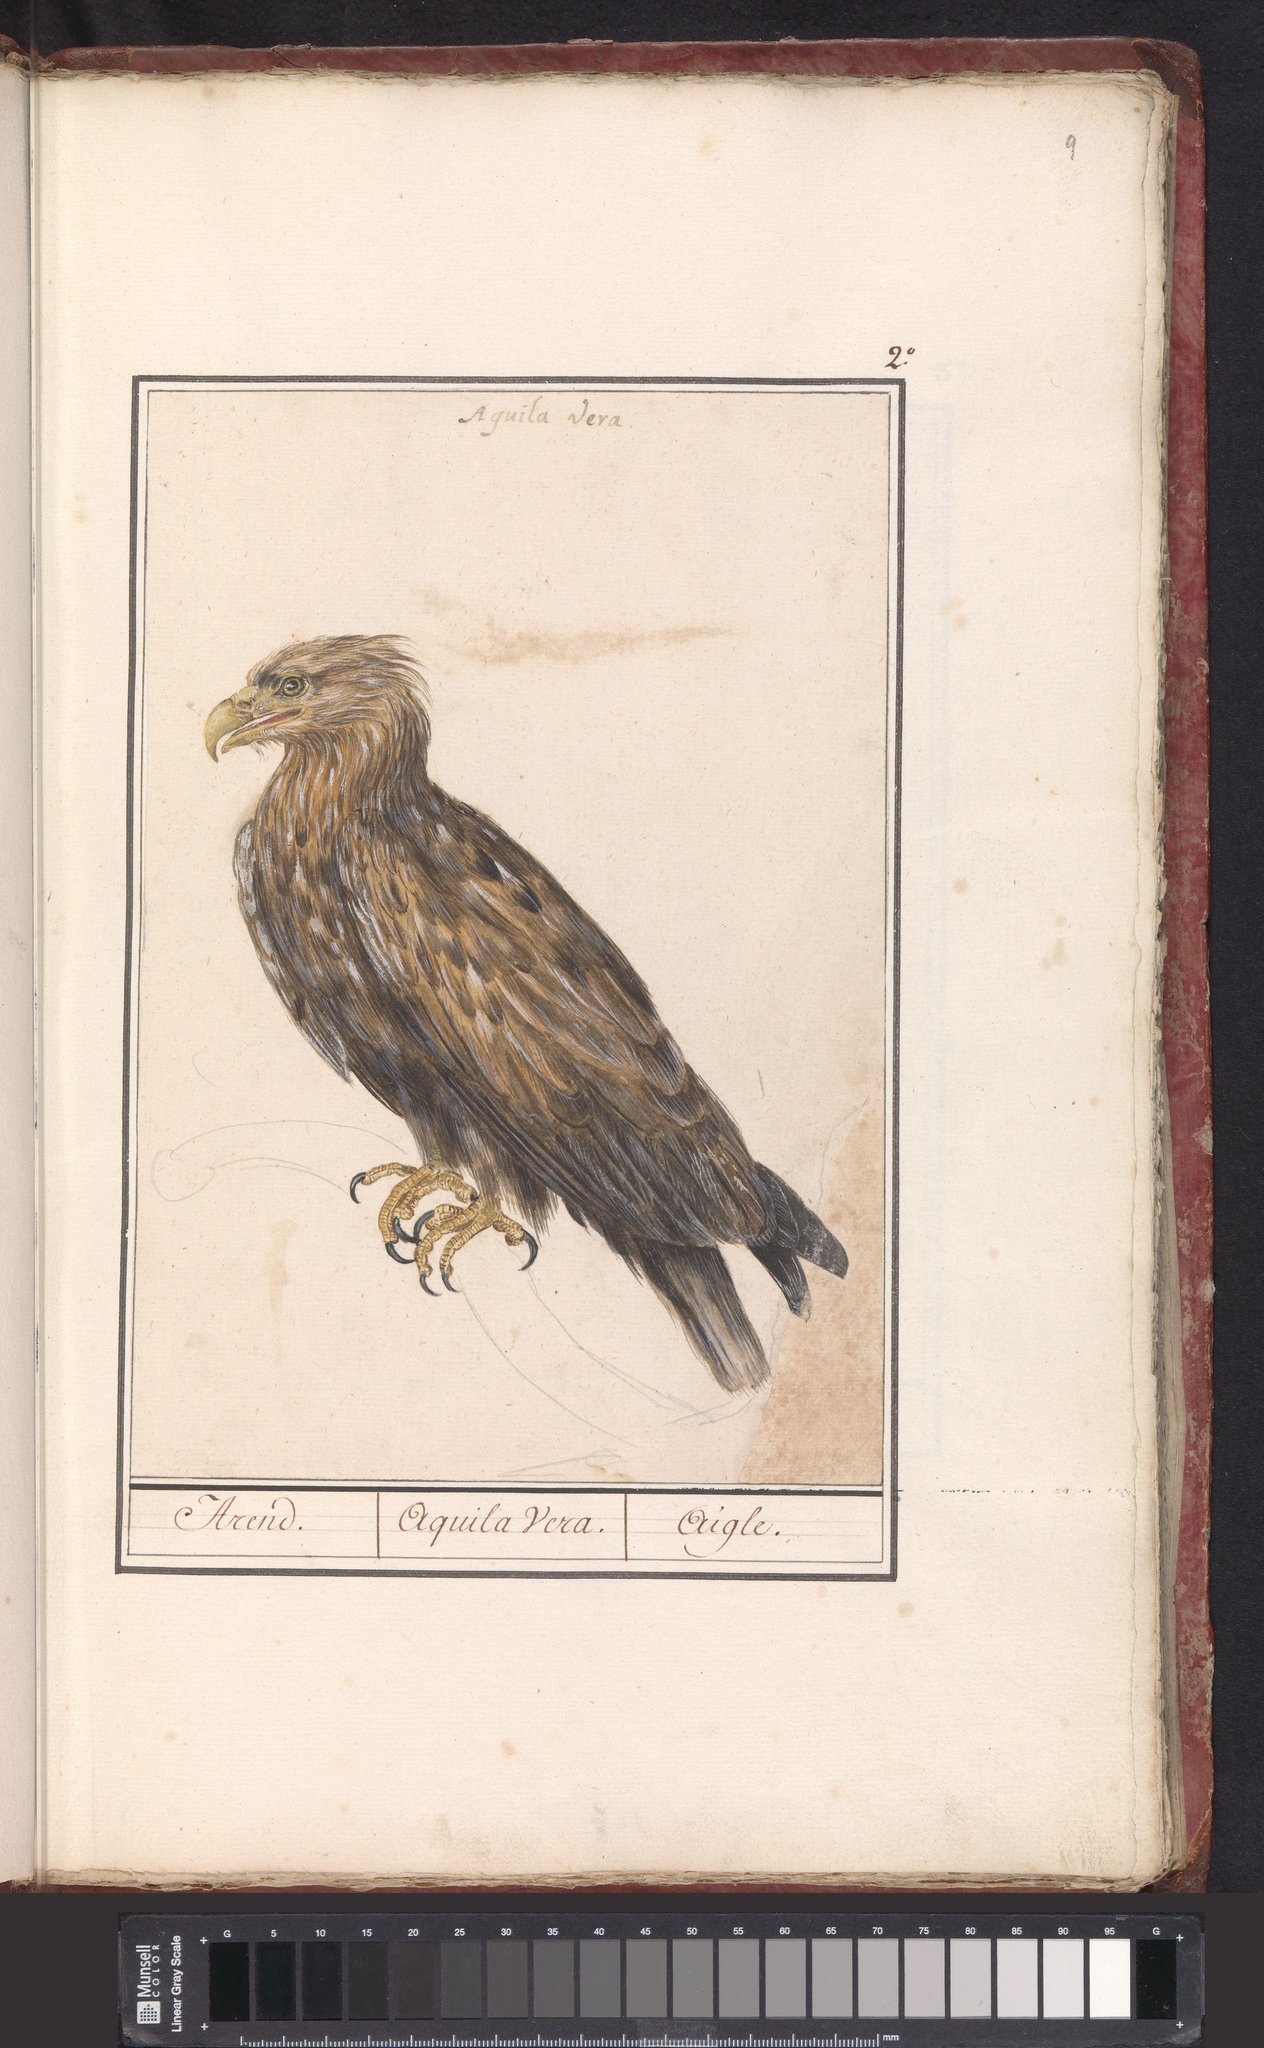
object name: drawing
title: Golden Eagle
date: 1596-1610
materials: paint, ink, paper, pencil, watercolor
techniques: brush, pen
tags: predatory birds: golden eagle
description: Steenarend. Genummerd rechtsboven: 2. Bovenaan de Latijnse naam. Onderdeel van het eerste album met tekeningen van vogels. Derde van twaalf albums met tekeningen van dieren, vogels en planten bekend rond 1600, gemaakt in opdracht van keizer Rudolf II. Met toelichting in Nederlands, Latijn en Frans.